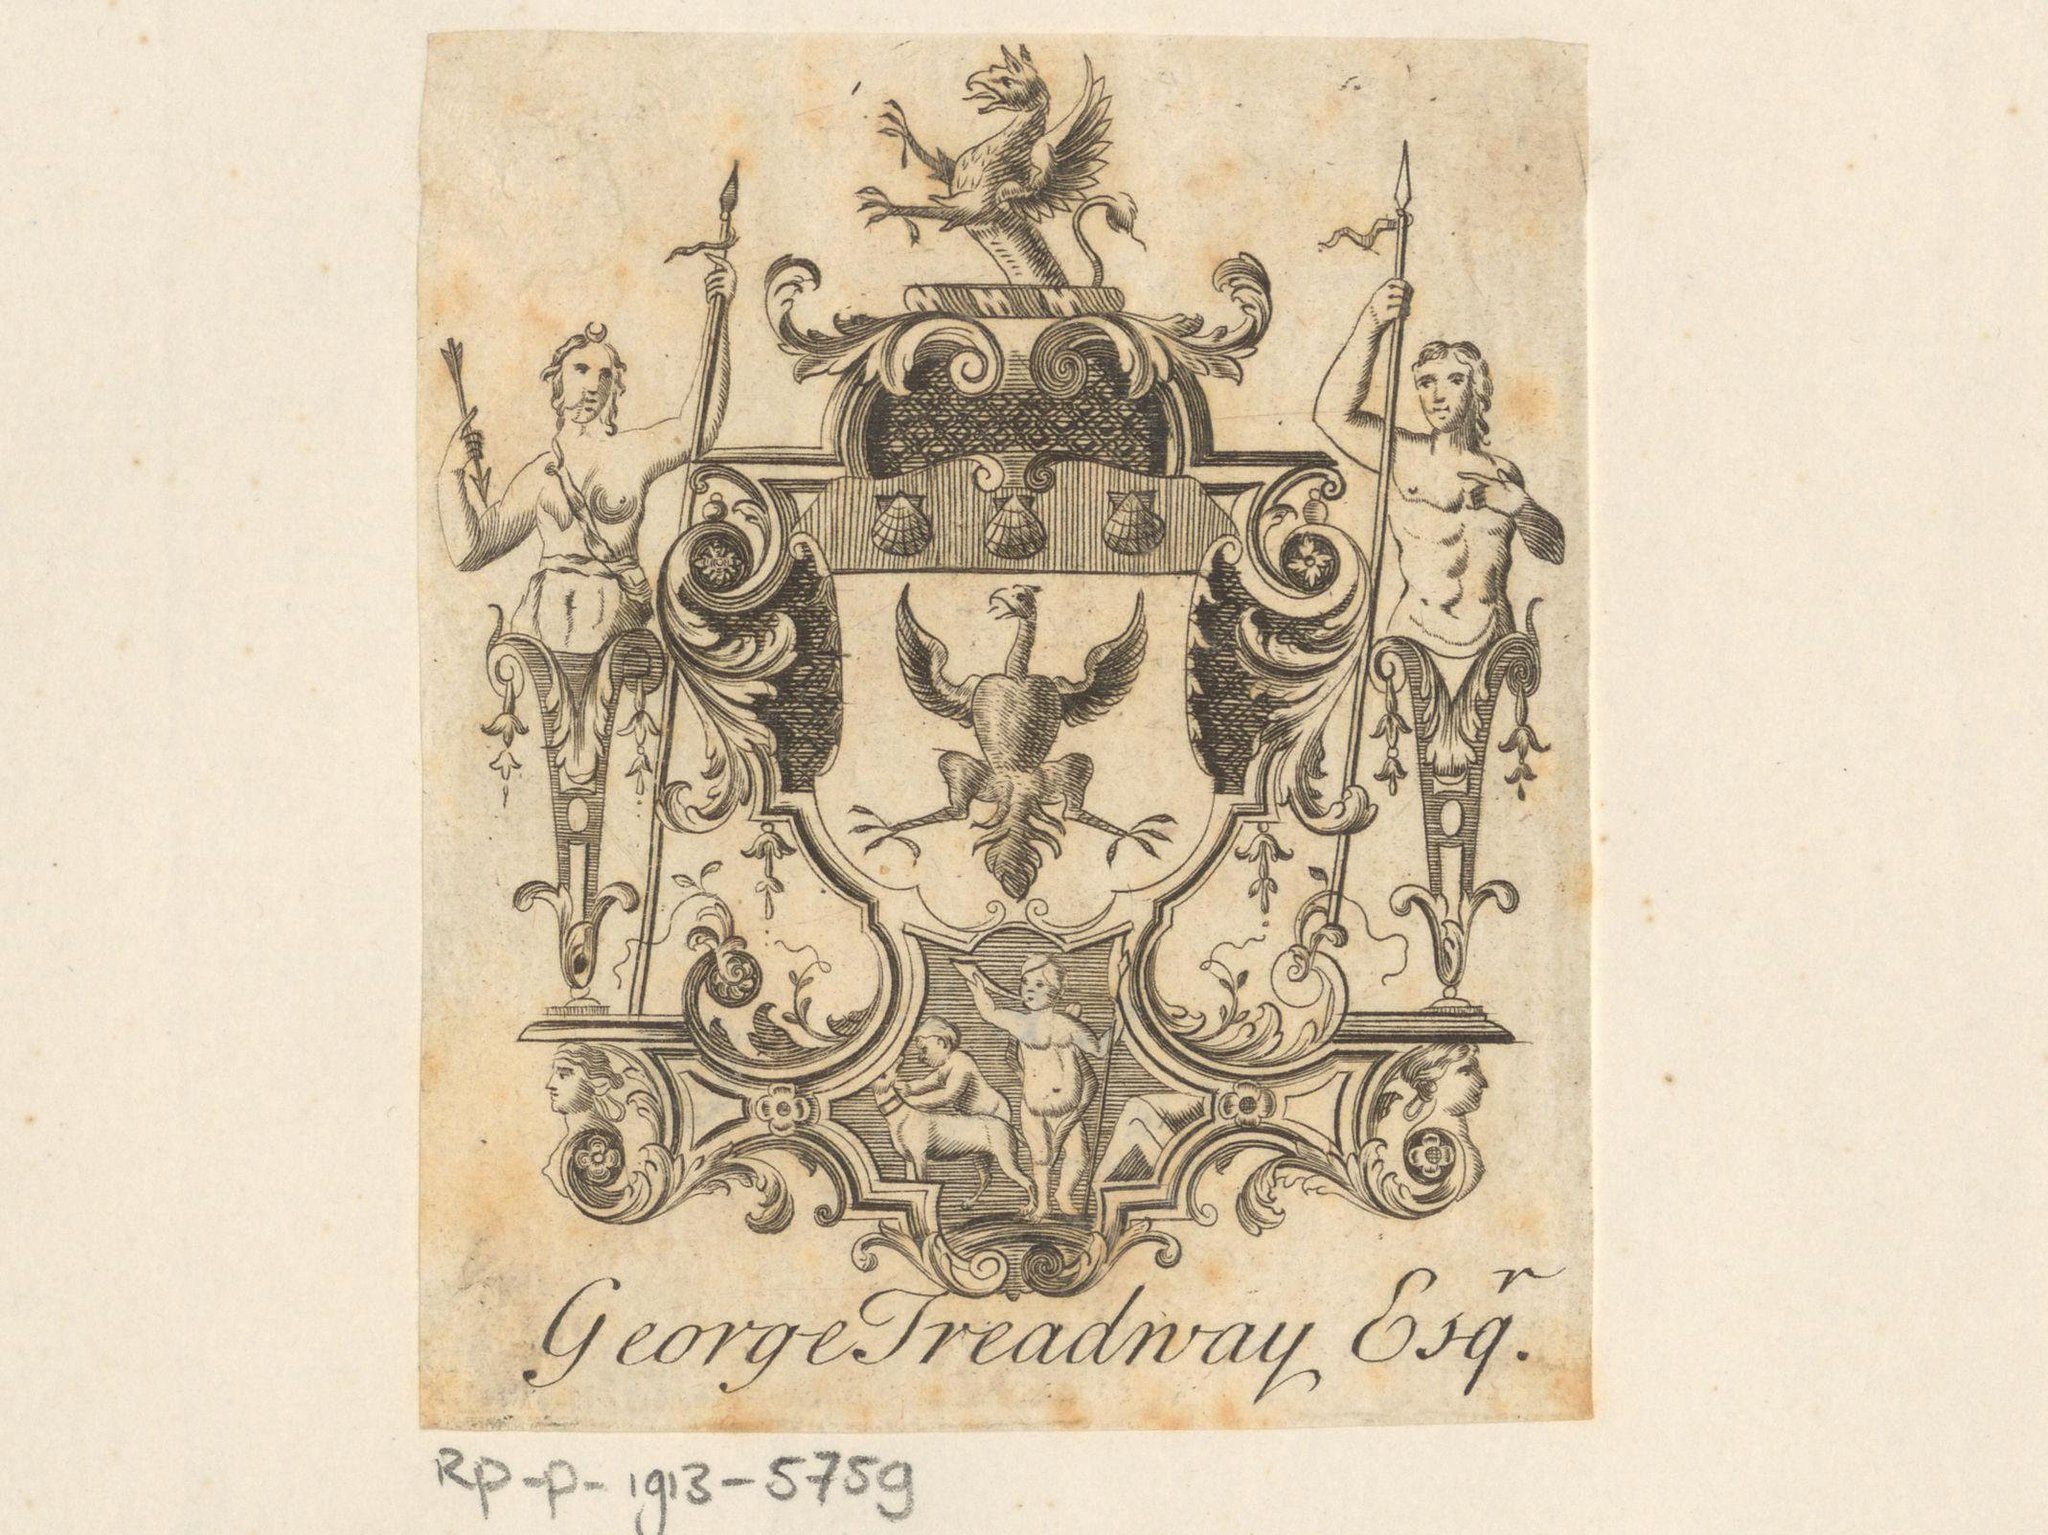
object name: bookplate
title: Ex libris van George Treadway Esqr.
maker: Anonymous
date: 1650-1799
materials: paper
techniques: engraving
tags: armorial bearing, heraldry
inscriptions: collector's mark: Lugt 2233, collector's mark: Lugt 2760